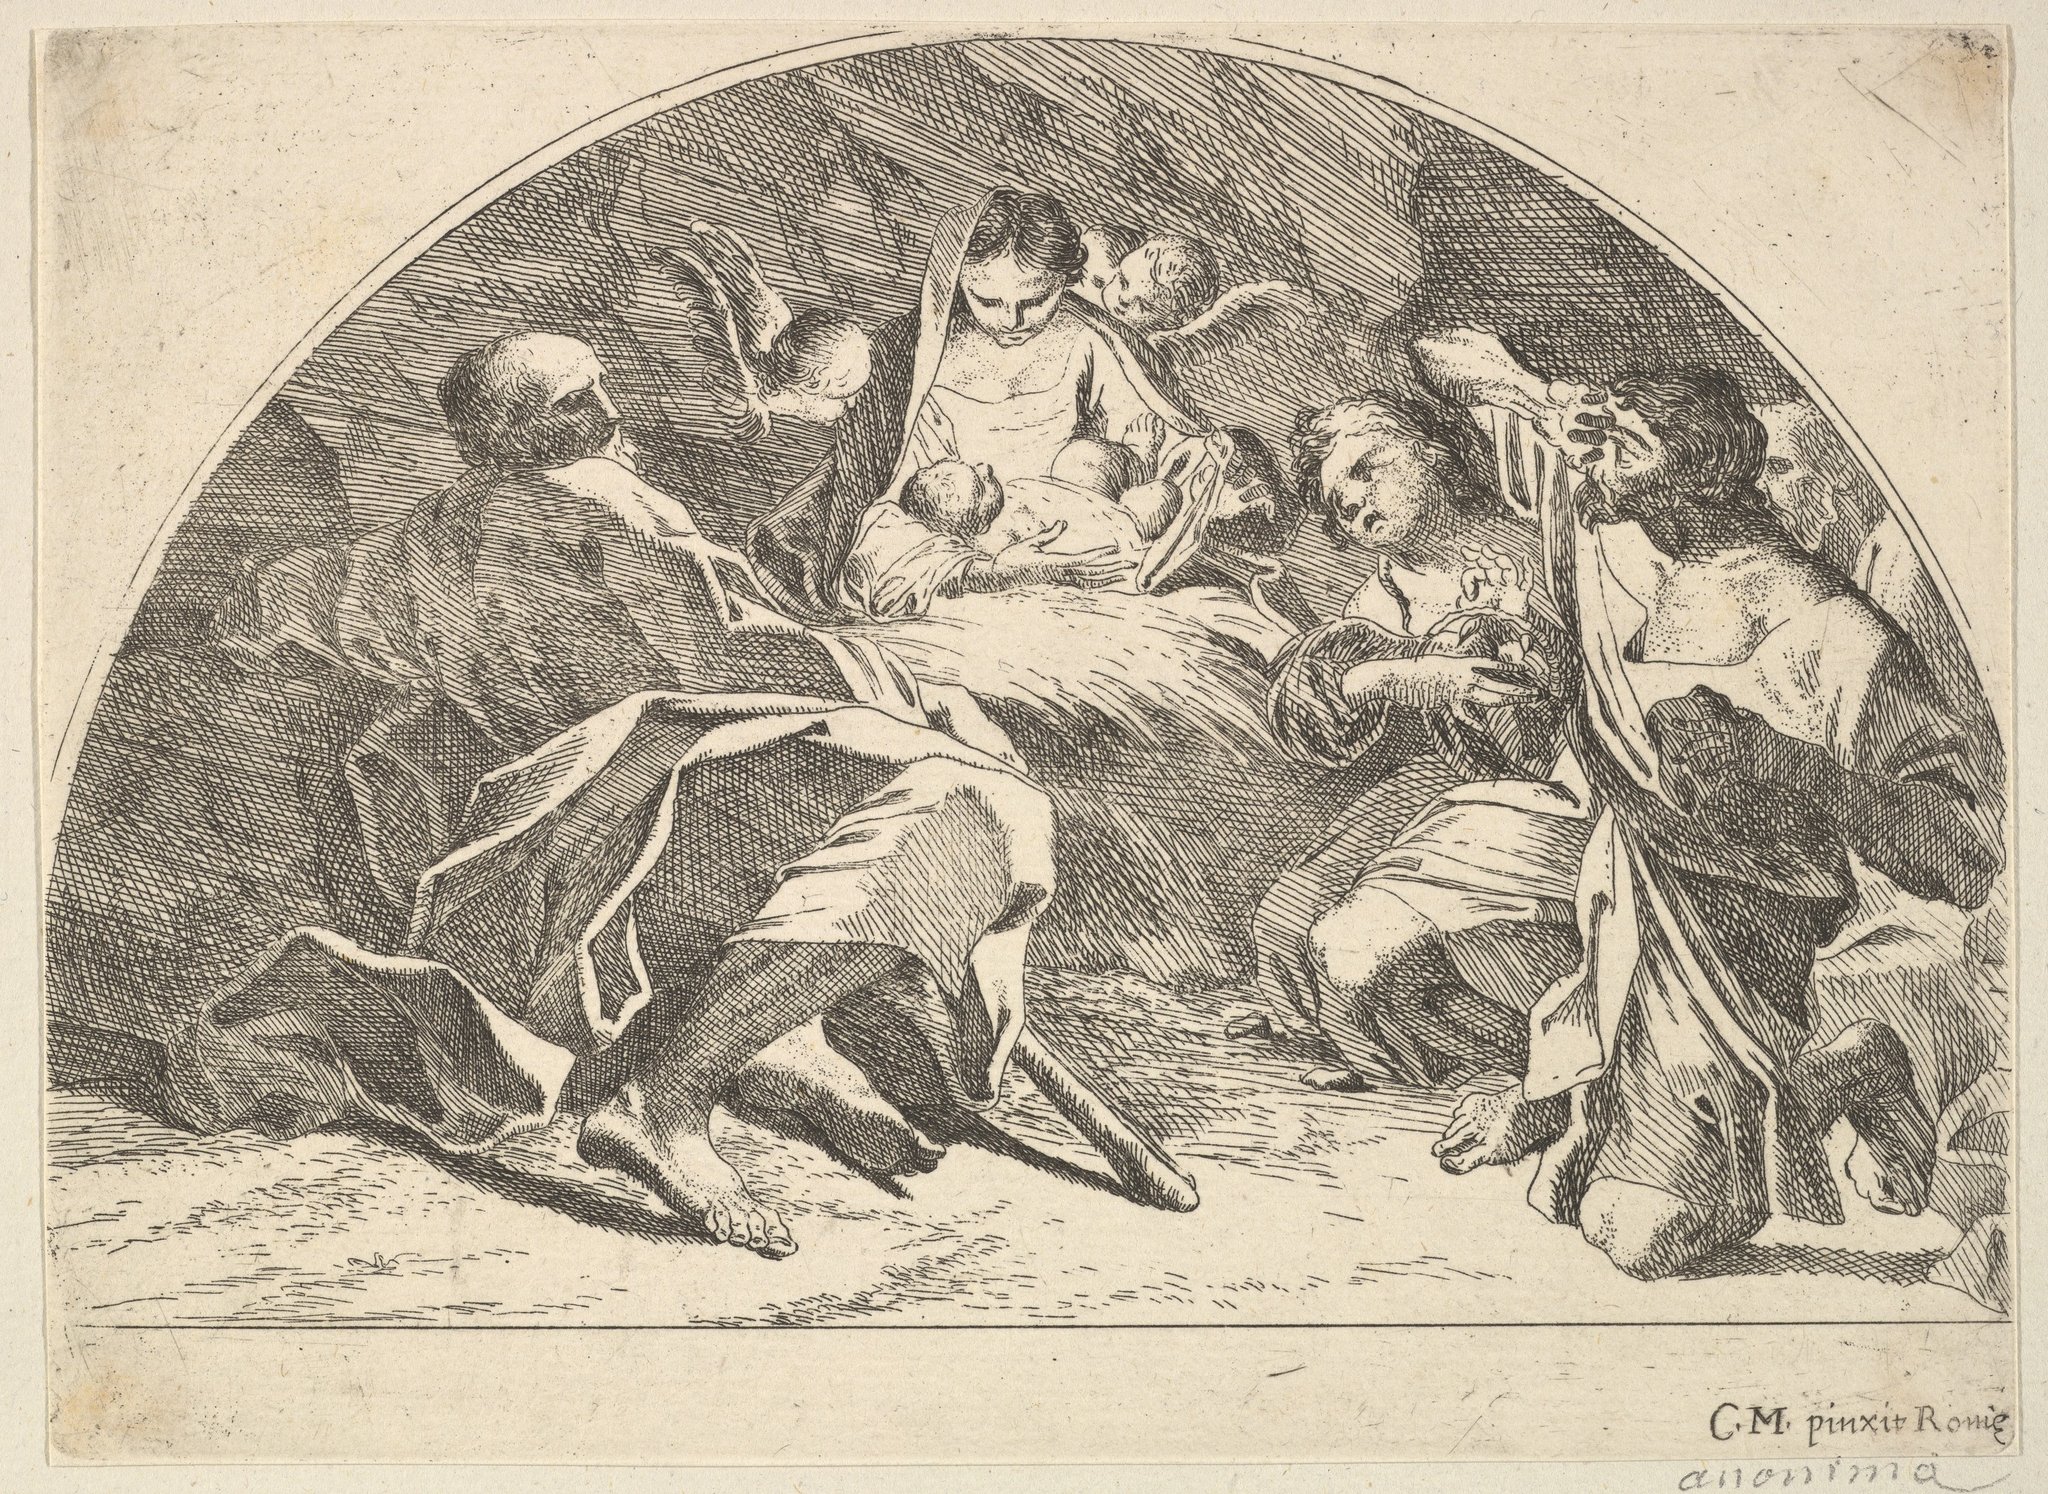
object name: print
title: Nativity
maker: robert van audenaerde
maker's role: artist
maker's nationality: flemish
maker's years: 1663-1743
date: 1680-1743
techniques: etching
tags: angels,madonna and child,nativity